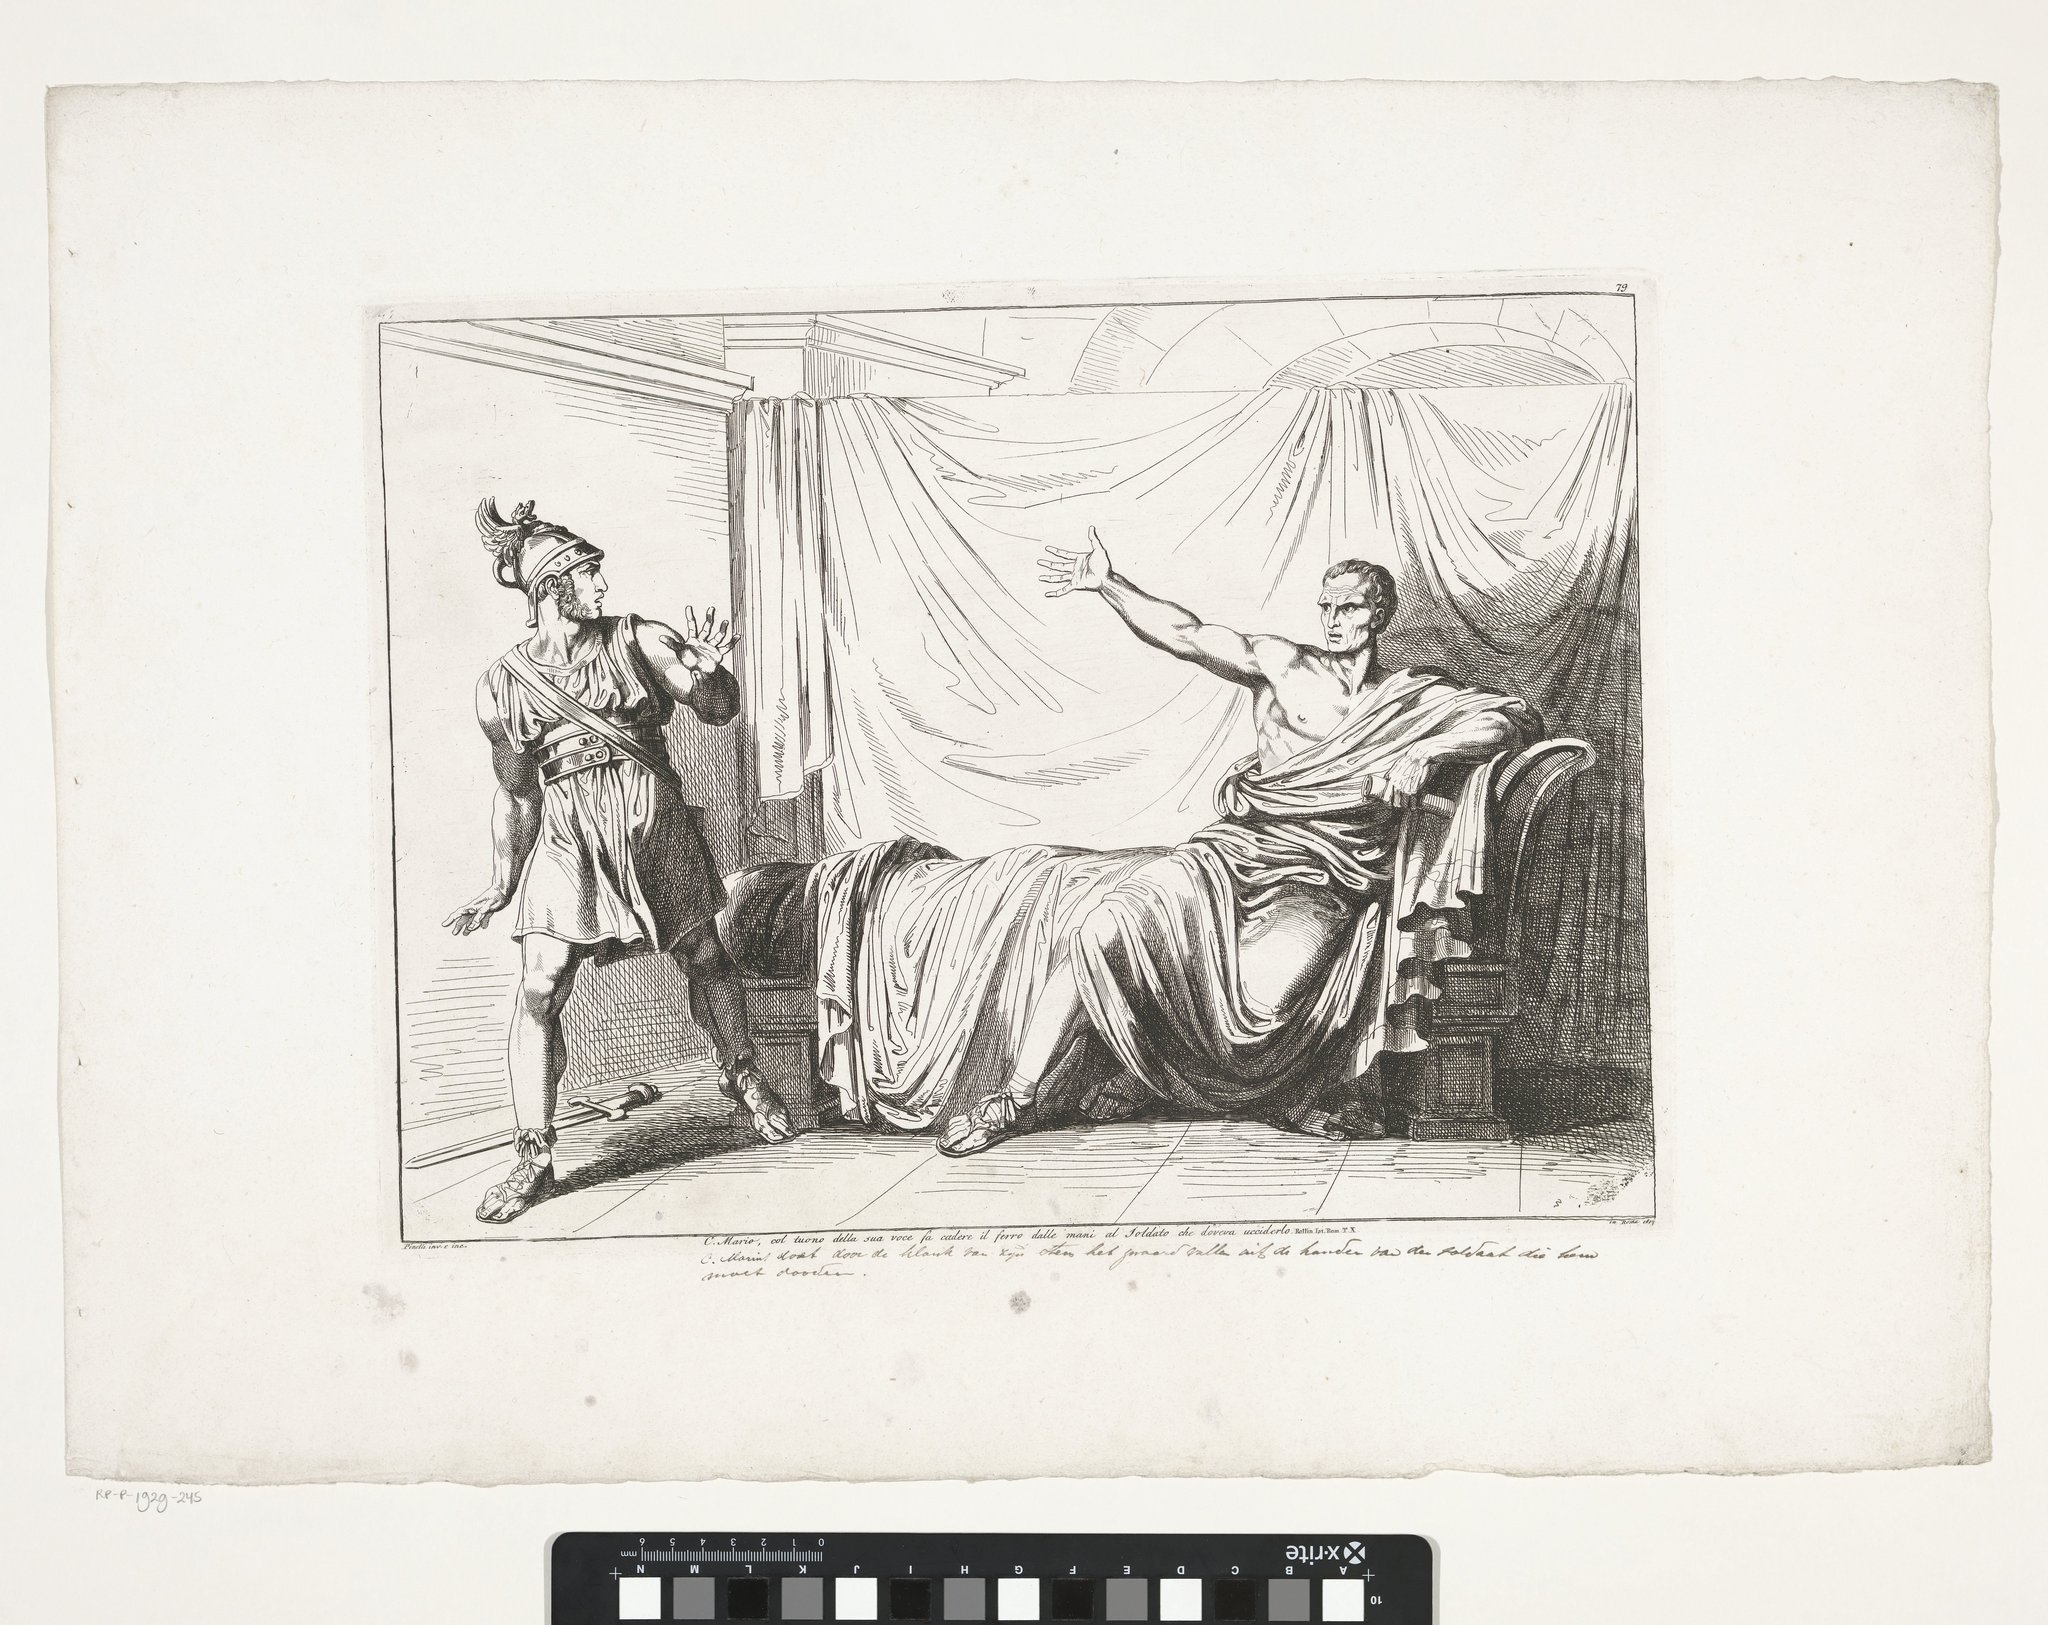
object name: print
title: C. Mario, col tuono della sua voce fa cadere il ferro dalle mani al Soldato che doveva ucciderlo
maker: bartolomeo pinelli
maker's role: draughtsman, print maker, sculptor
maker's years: 1781-1835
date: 1818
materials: paper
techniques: etching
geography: rome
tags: (story of) gaius marius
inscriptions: collector's mark: Lugt 2228, inscription: ‘C. Mario, col tuono della sua voce fa cadere il ferro dalle mani al Soldato che doveva ucciderlo’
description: De soldaat die op het punt staat Gaius Marius te vermoorden laat zijn zwaard vallen wanneer Gaius Marius tegen hem begint te praten.